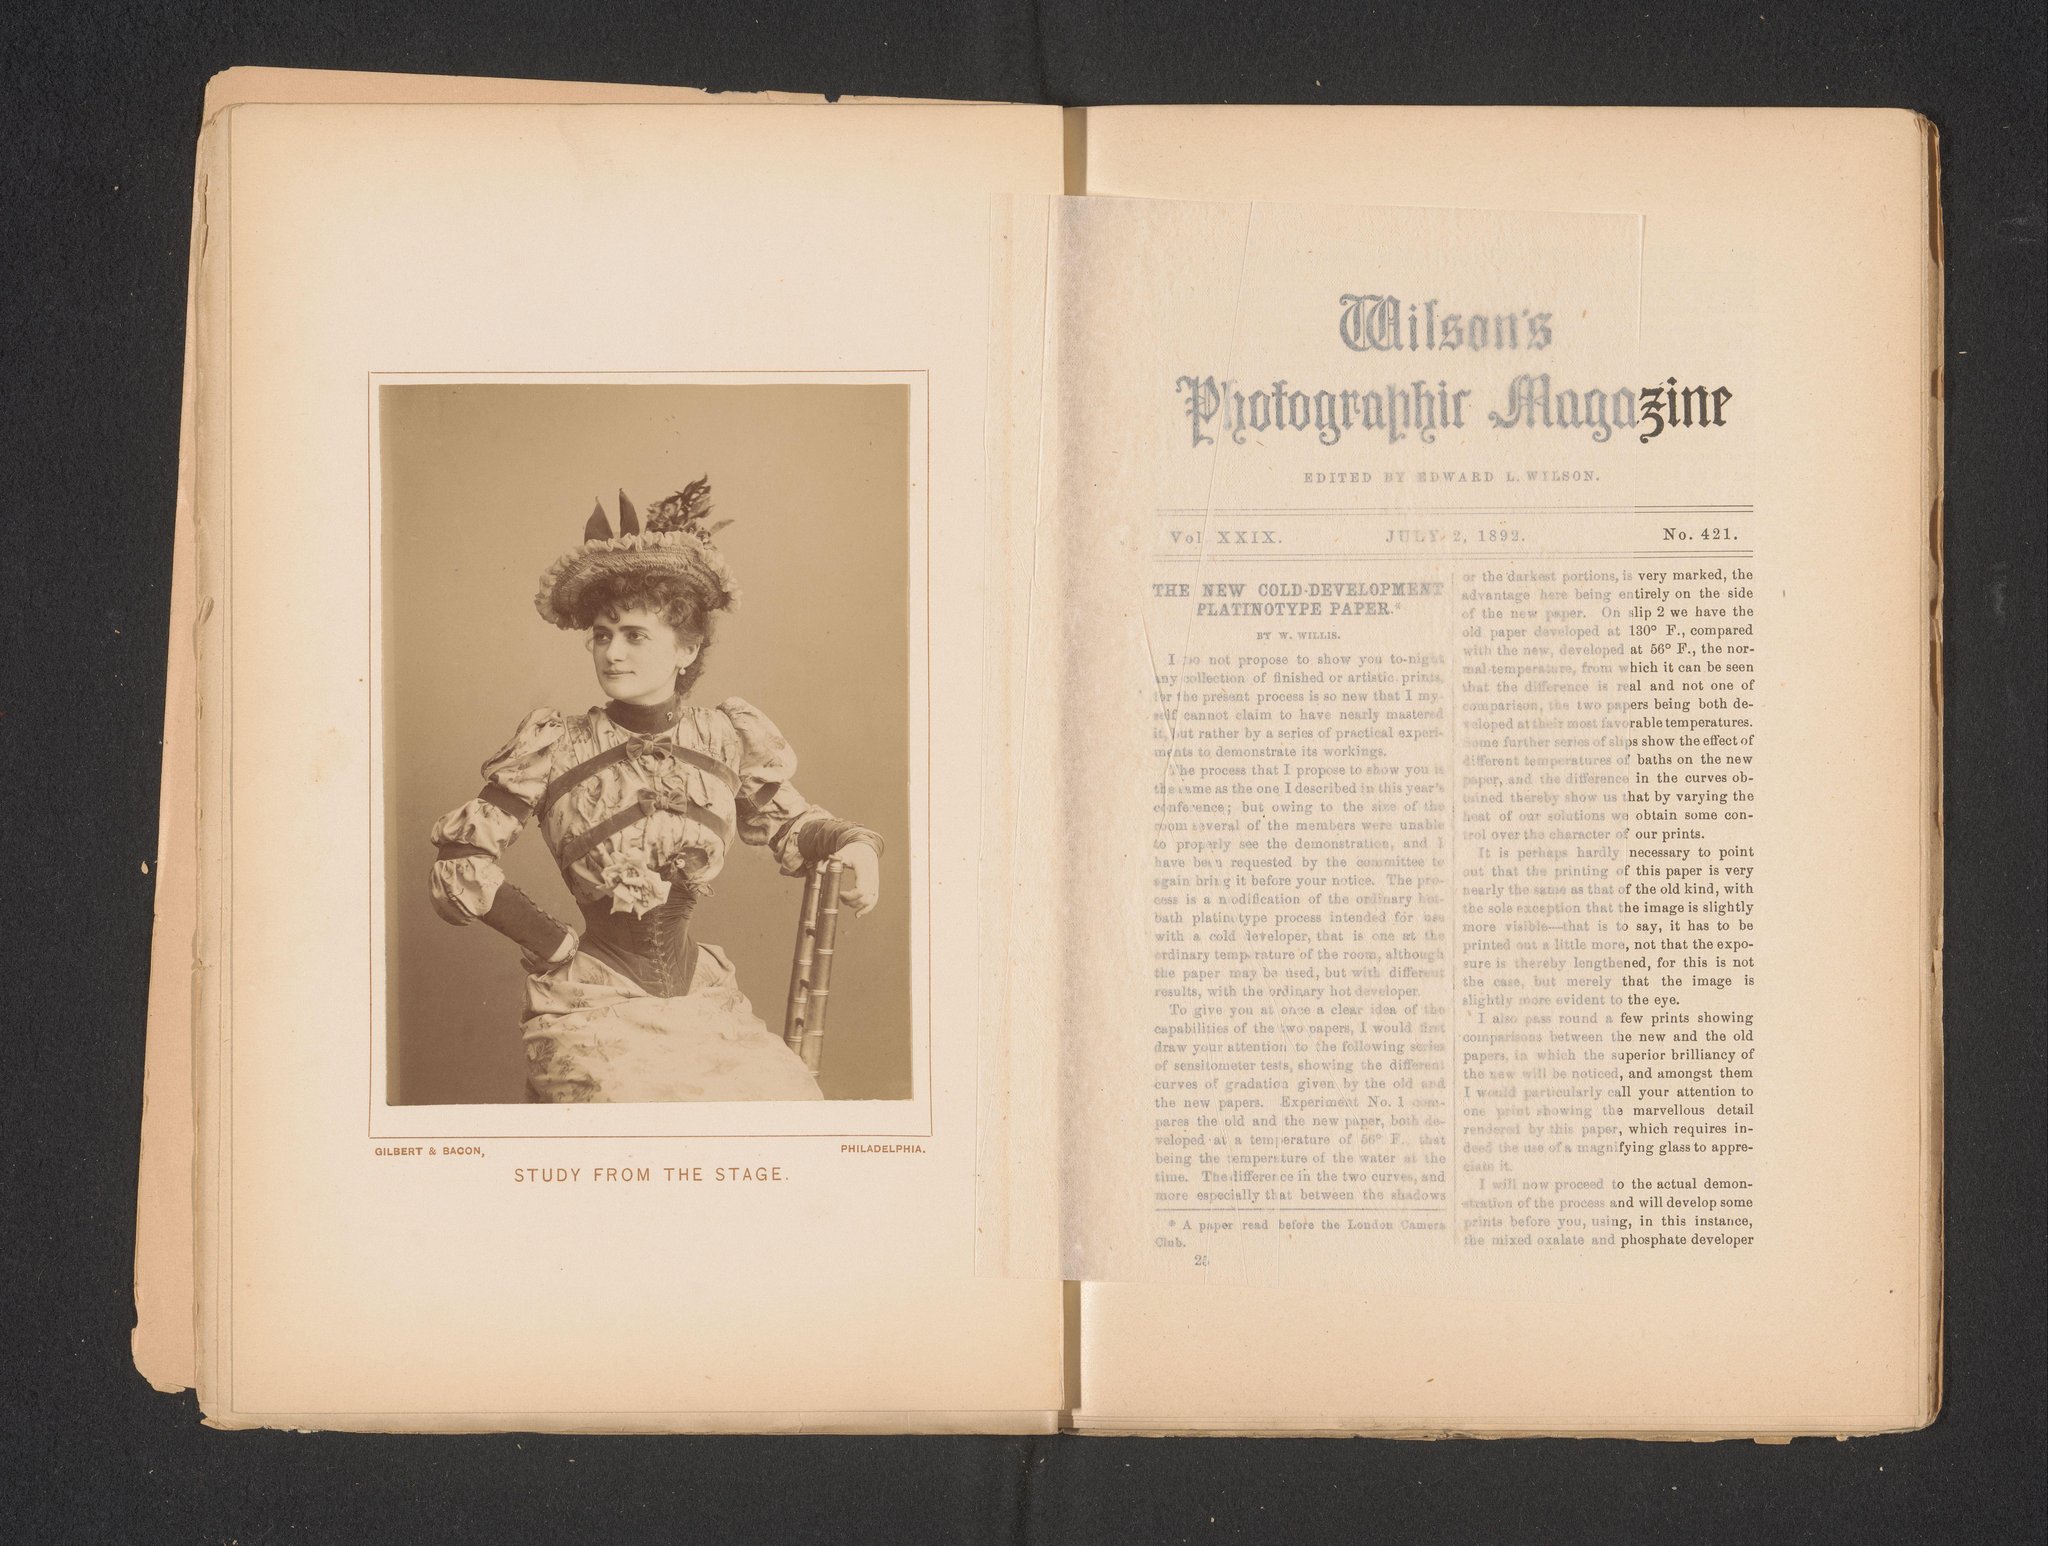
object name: page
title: Study from the Stage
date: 1887-1892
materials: photographic support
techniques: albumen print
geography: philadelphia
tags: stage costume, historical persons not known by name - bb - woman